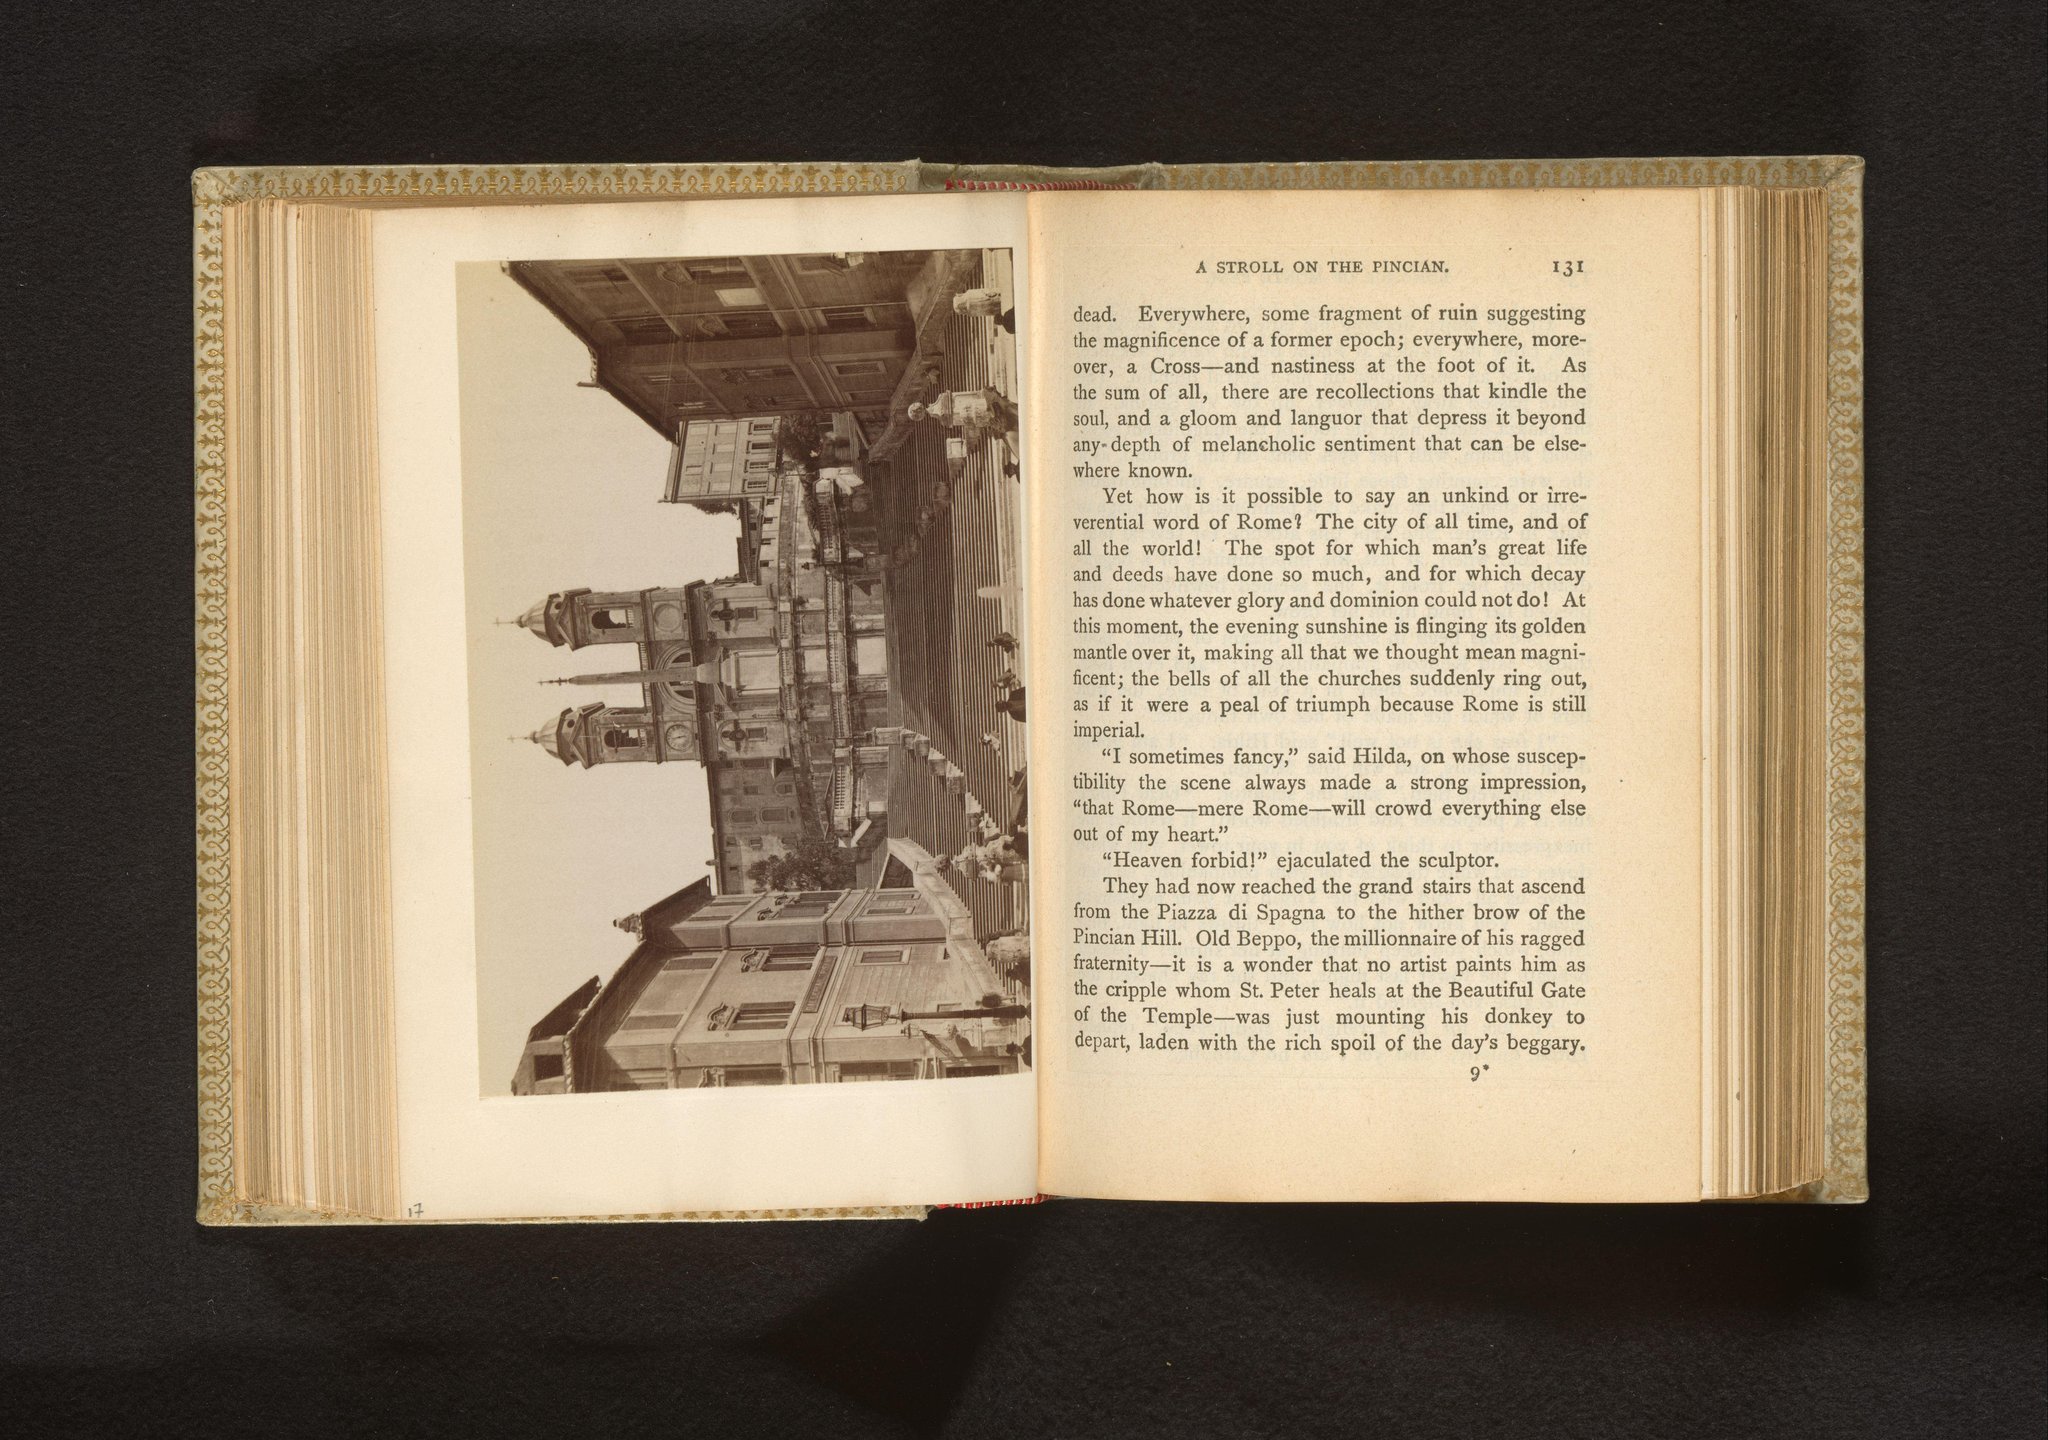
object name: page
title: Gezicht op de Spaanse trappen in Rome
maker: Anonymous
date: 1850-1860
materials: photographic support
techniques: albumen print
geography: rome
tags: square, place, circus, etc.